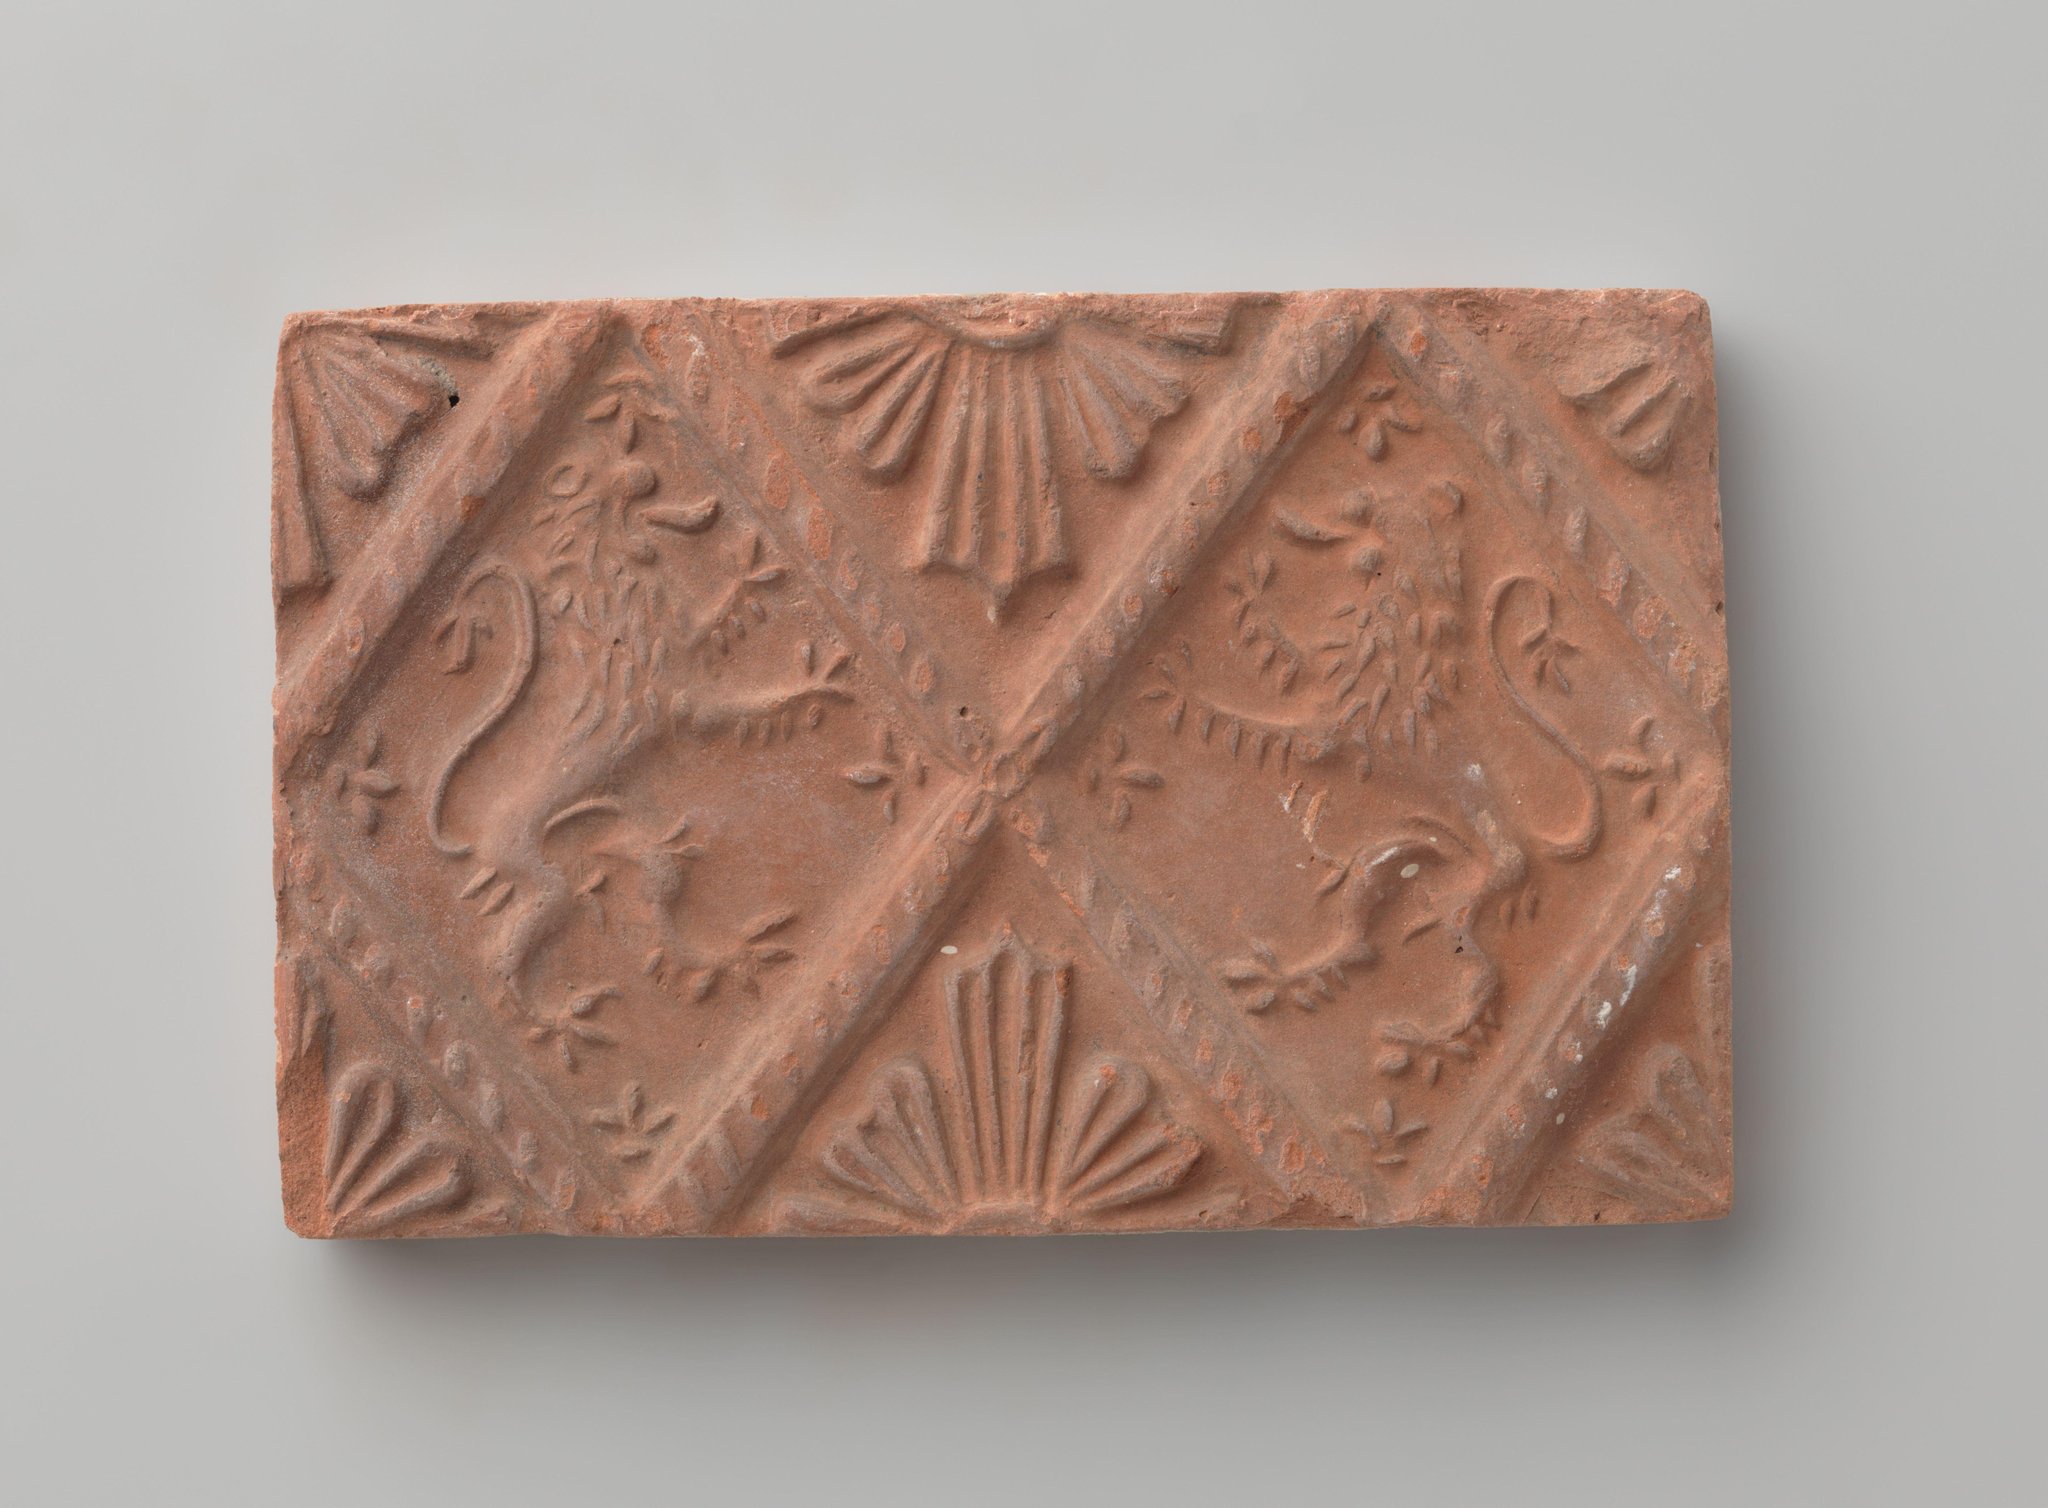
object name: hearthstone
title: Haardsteen met voorstelling van twee klimmende leeuwen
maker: Anonymous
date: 1875-1900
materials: earthenware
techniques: printing, firing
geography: netherlands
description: Haardsteen met voorstelling van twee klimmende leeuwen, geplaatst in geprofileerde ruit. De halve ruiten aan de boven- en onderkant zijn opgevuld met stermotief.